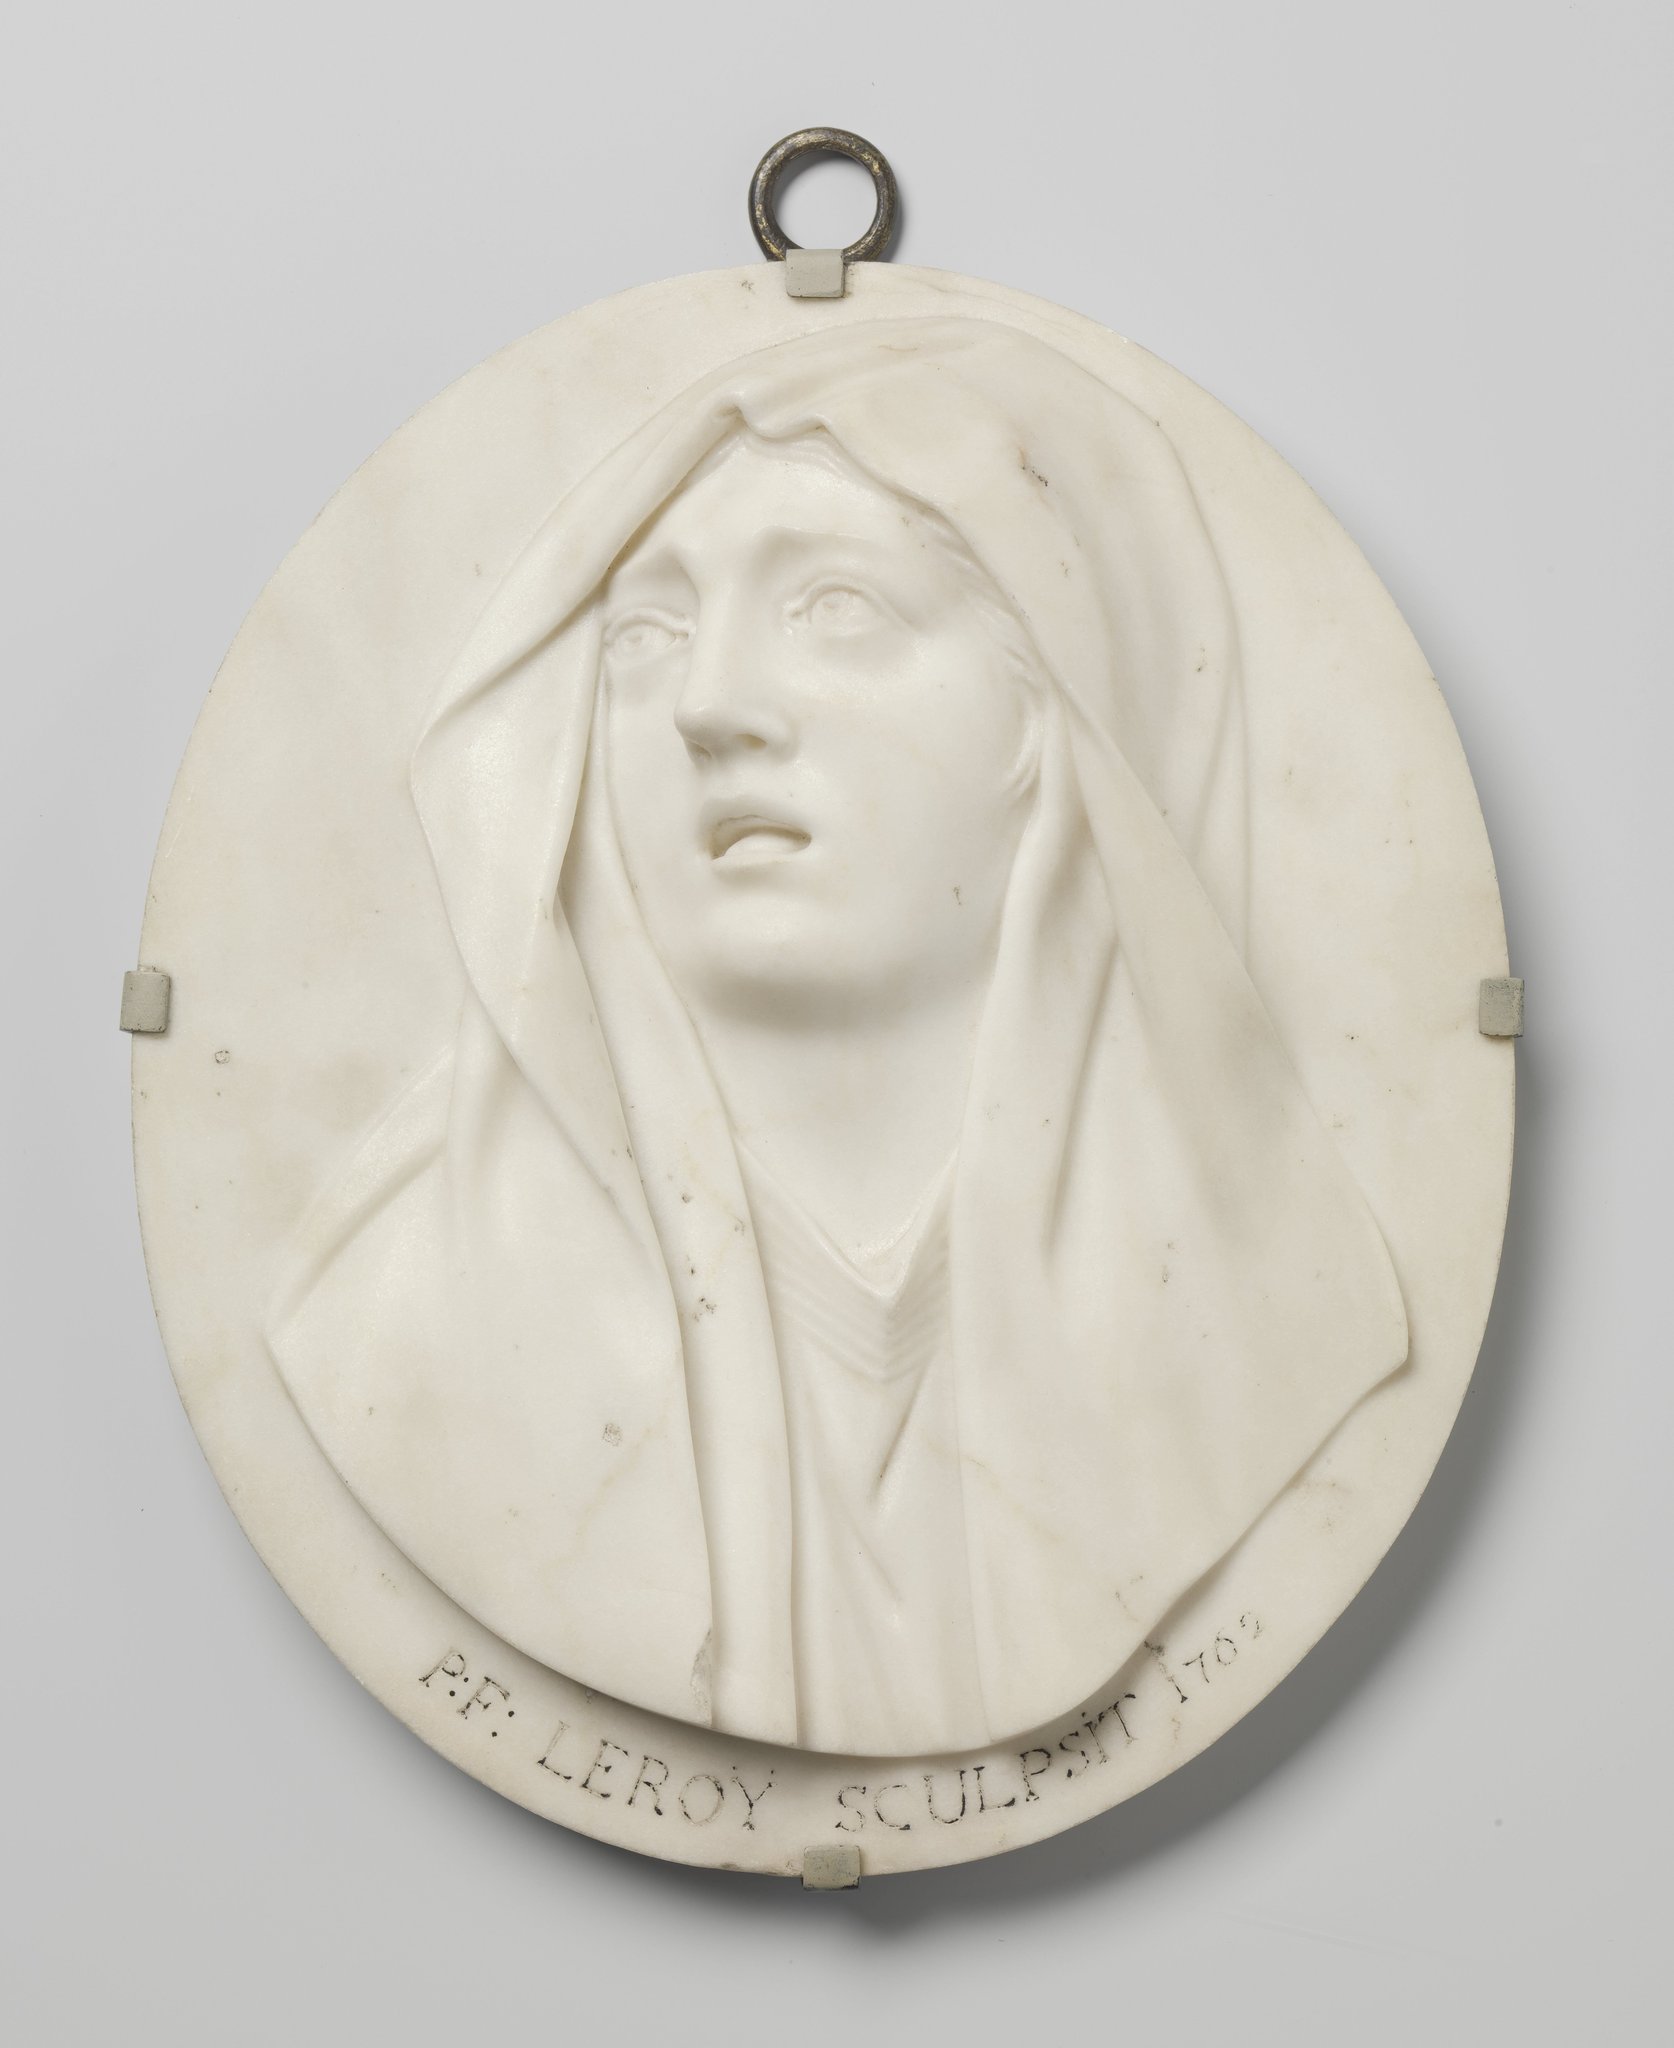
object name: sculpture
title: Maria als Mater dolorosa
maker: pierre-françois le roy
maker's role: sculptor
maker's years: 1739-1812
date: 1762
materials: marble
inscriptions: signature: ‘P:F: LEROY sculpsit 1762’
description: Zij wendt het hoofd naar links omhoog. De mond is geopend. Zij draagt een kleed dat aan de hals met een band is versierd en over het hoofd een sluier. Het reliëf heeft een ovaalvormige achtergrond.